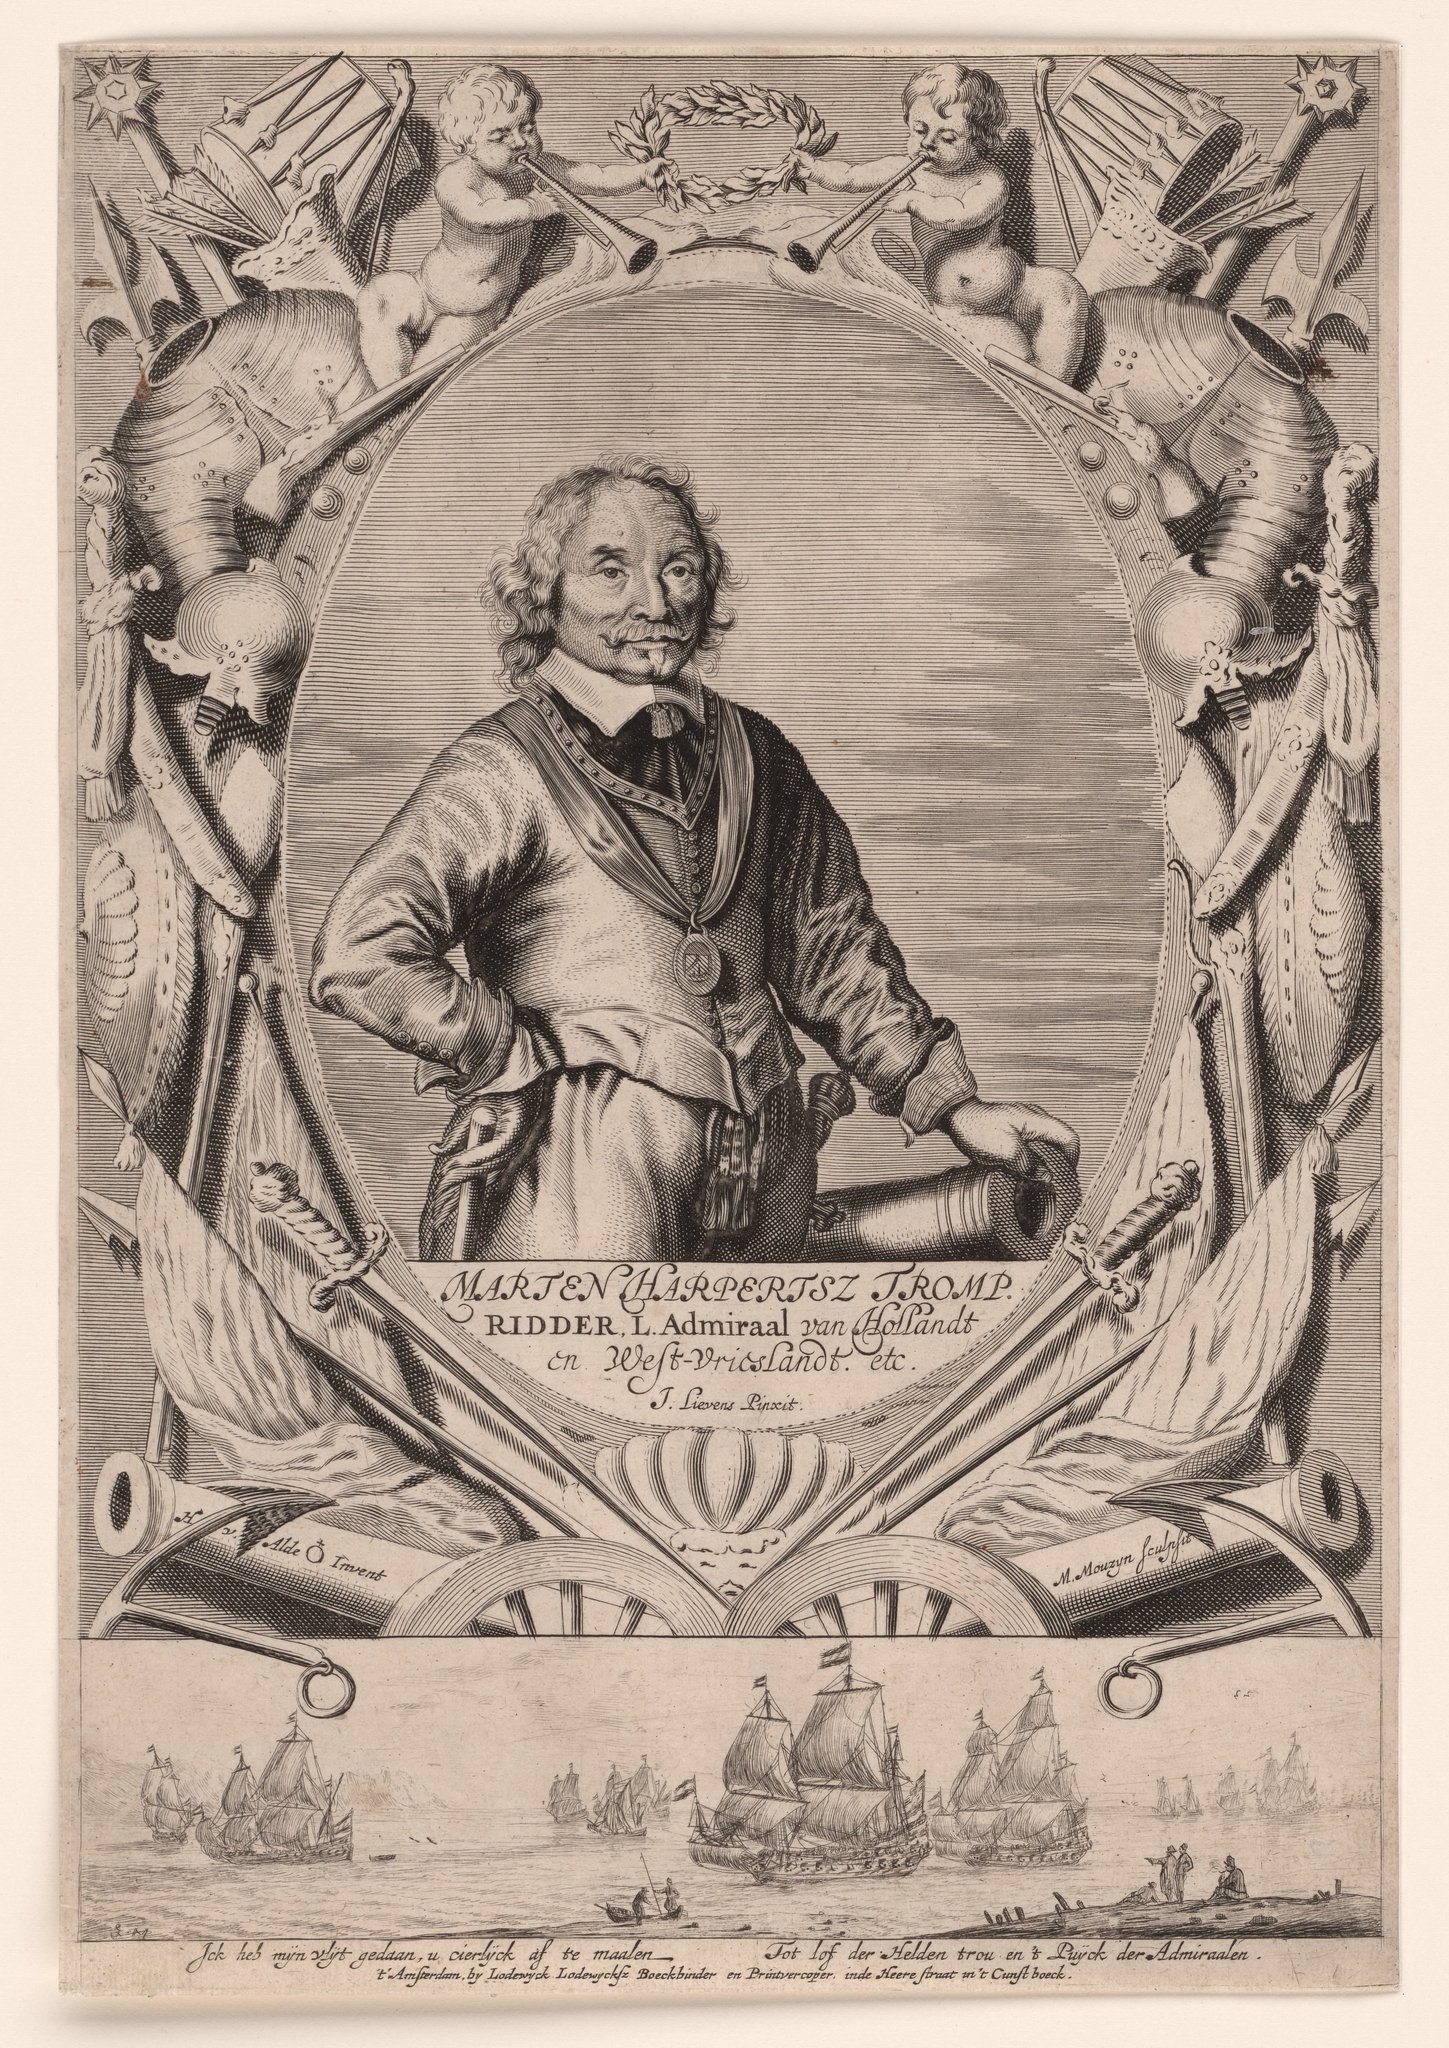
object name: print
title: Portret van Maarten Harpertszoon Tromp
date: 1650-1655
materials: paper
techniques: engraving, etching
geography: amsterdam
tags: brielle, maarten harpertszoon tromp, navy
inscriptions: collector's mark: Lugt 2228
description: Portret van admiraal Maarten Harpertszoon Tromp, zijn hand rustend op een kanon, de andere hand in zijn zijde. Het portret is gevat in ornamentele lijst met vlaggen, zwaarden, kanonnen, harnasdelen en wordt bekroond door twee putti, die een lauwerkrans ophouden. Onderaan in de marge een zeegezicht met zeilschepen. In het midden wellicht Tromps schip, de Brederode.